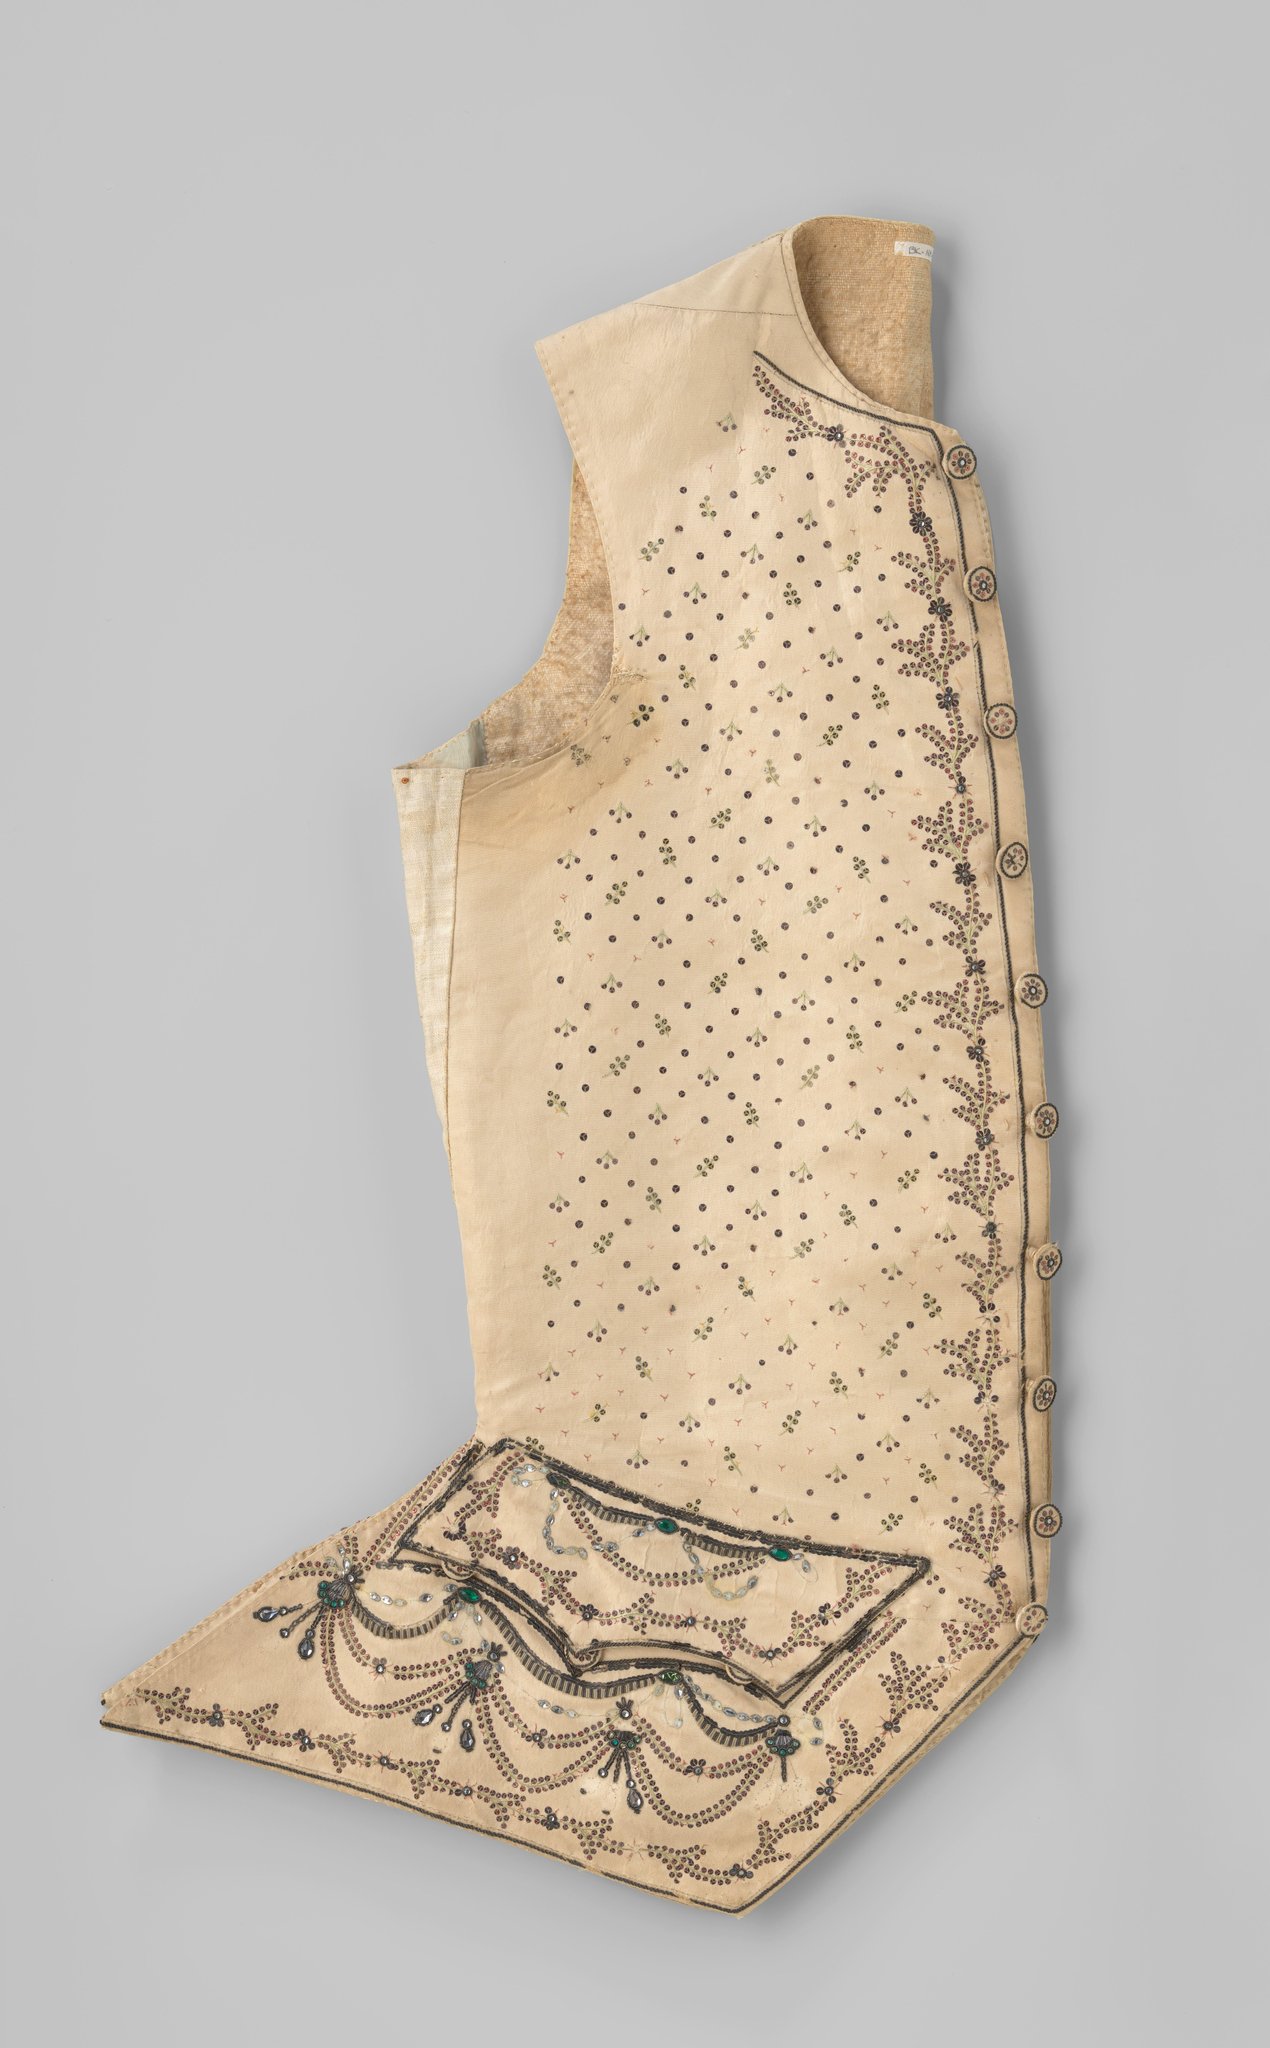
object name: vest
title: Vest van crème ripszijde, meerkleurig geborduurd met noppen, bloemen, bladranken en lambrequins met pailletten, gekleurde stenen en biezen van metaaldraad; achter wit linnen.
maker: Anonymous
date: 1700-1800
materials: glass, linen, metal thread, silk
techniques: embroidered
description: Vest van roomkleurig ribzijde, geheel geborduurd met pailetten.